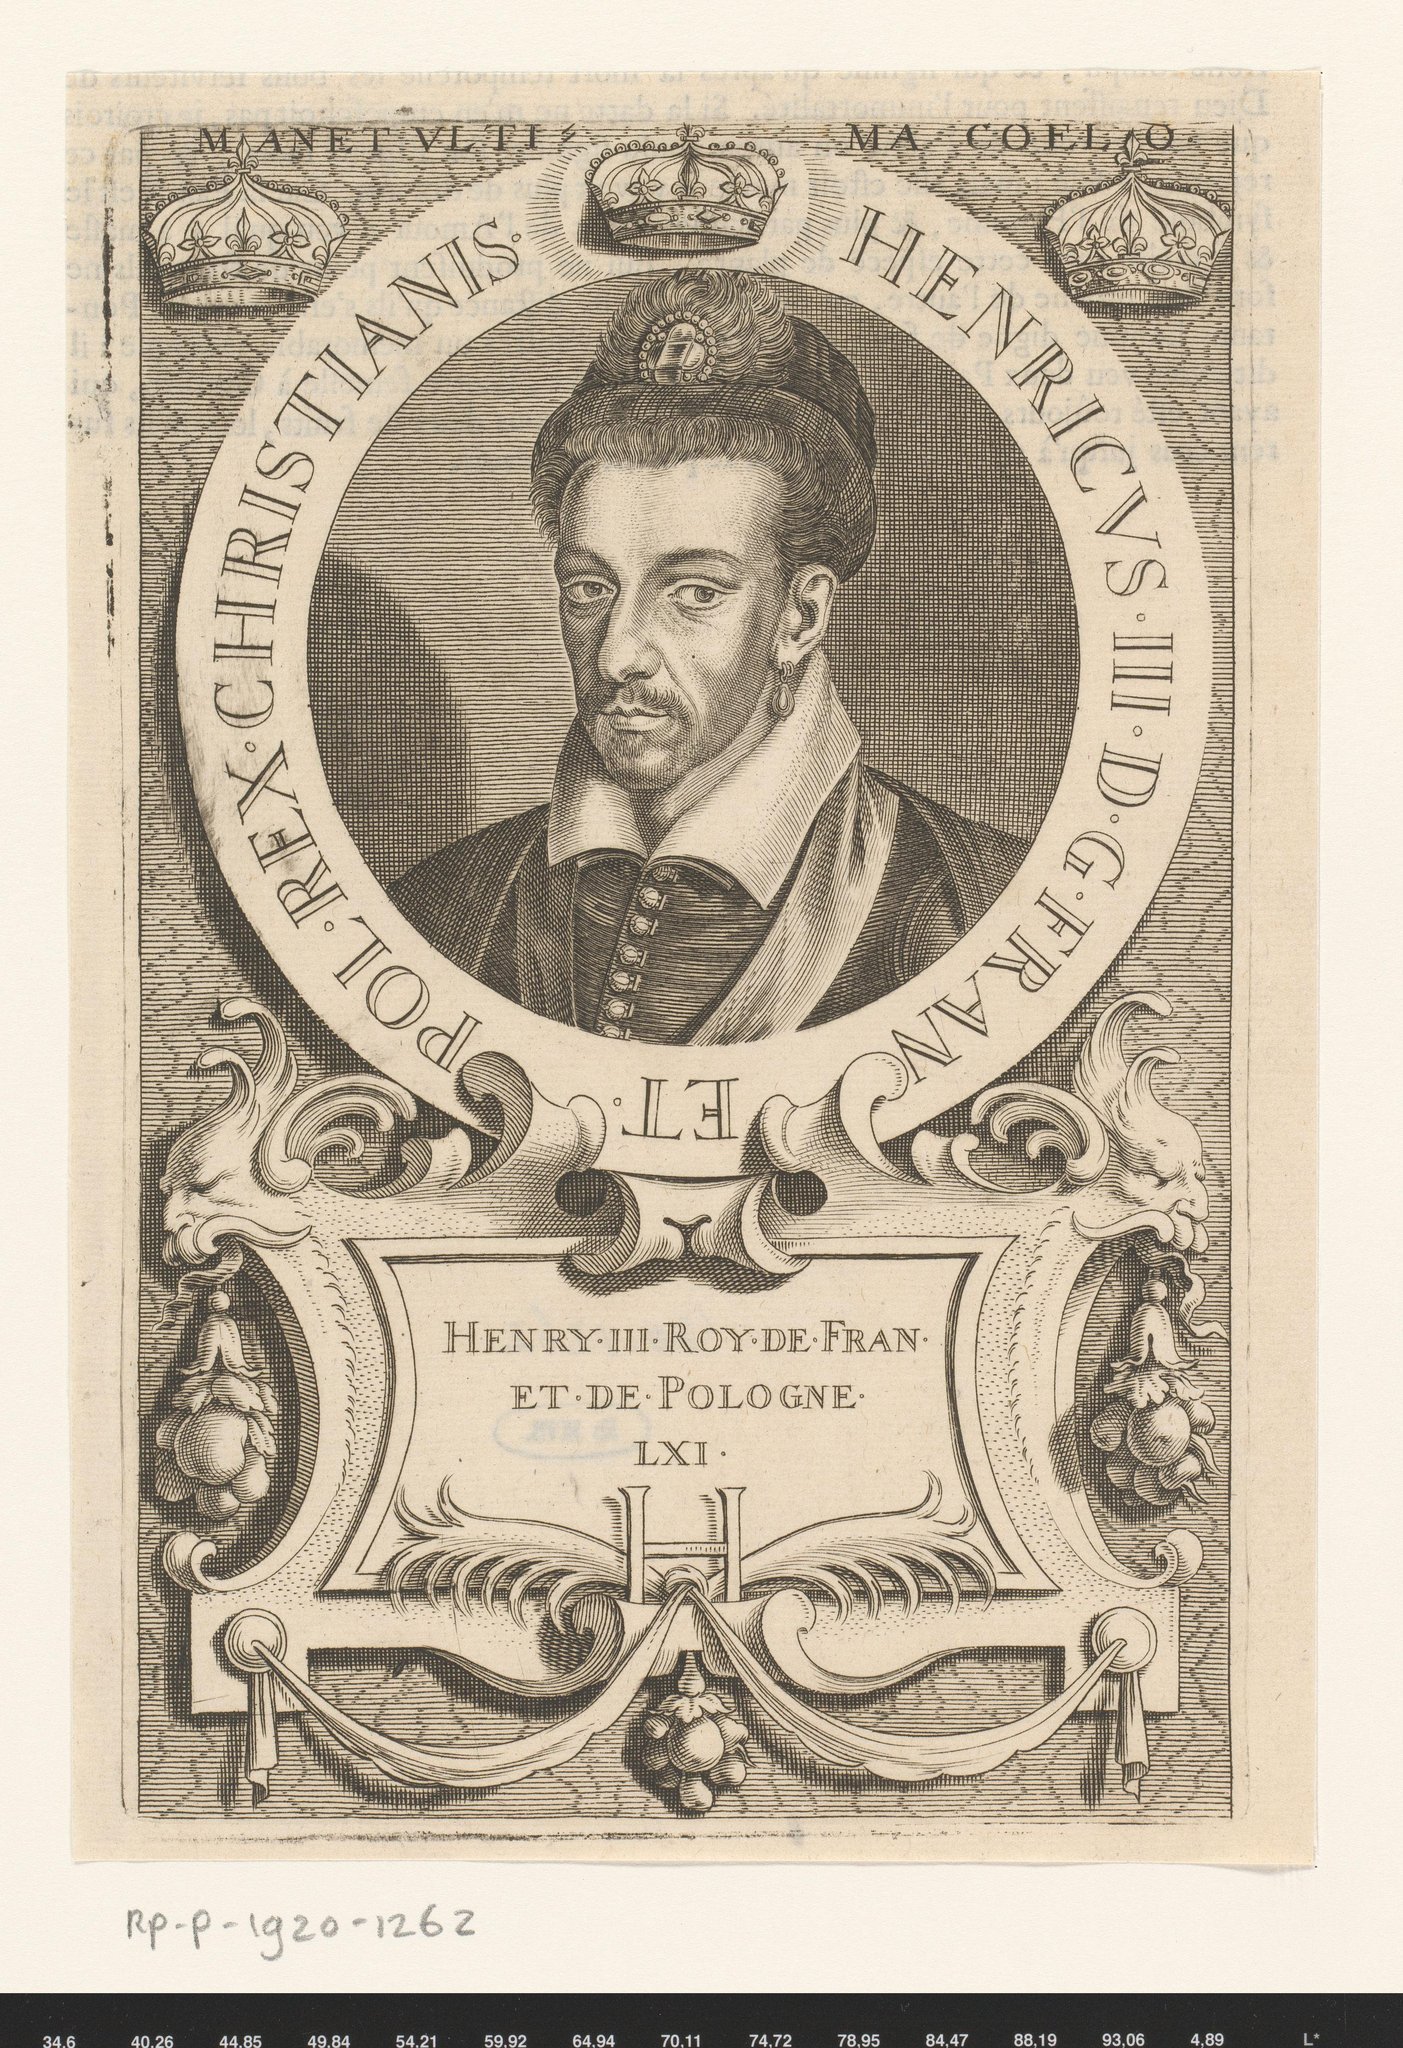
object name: print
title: Portret van Hendrik III van Frankrijk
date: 1685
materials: paper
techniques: engraving, letterpress printing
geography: paris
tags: hendrik iii (koning van frankrijk), historical persons, king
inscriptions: collector's mark: Lugt 2228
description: Prent uit: Mézeray, François Eudes de. Histoire de France, depuis Faramond jusqu'au regne de Louis le Juste. (...) Parijs: Denis Thierry, Jean Guignard en Claude Barbin, 1685, dl. 3, p. 330.